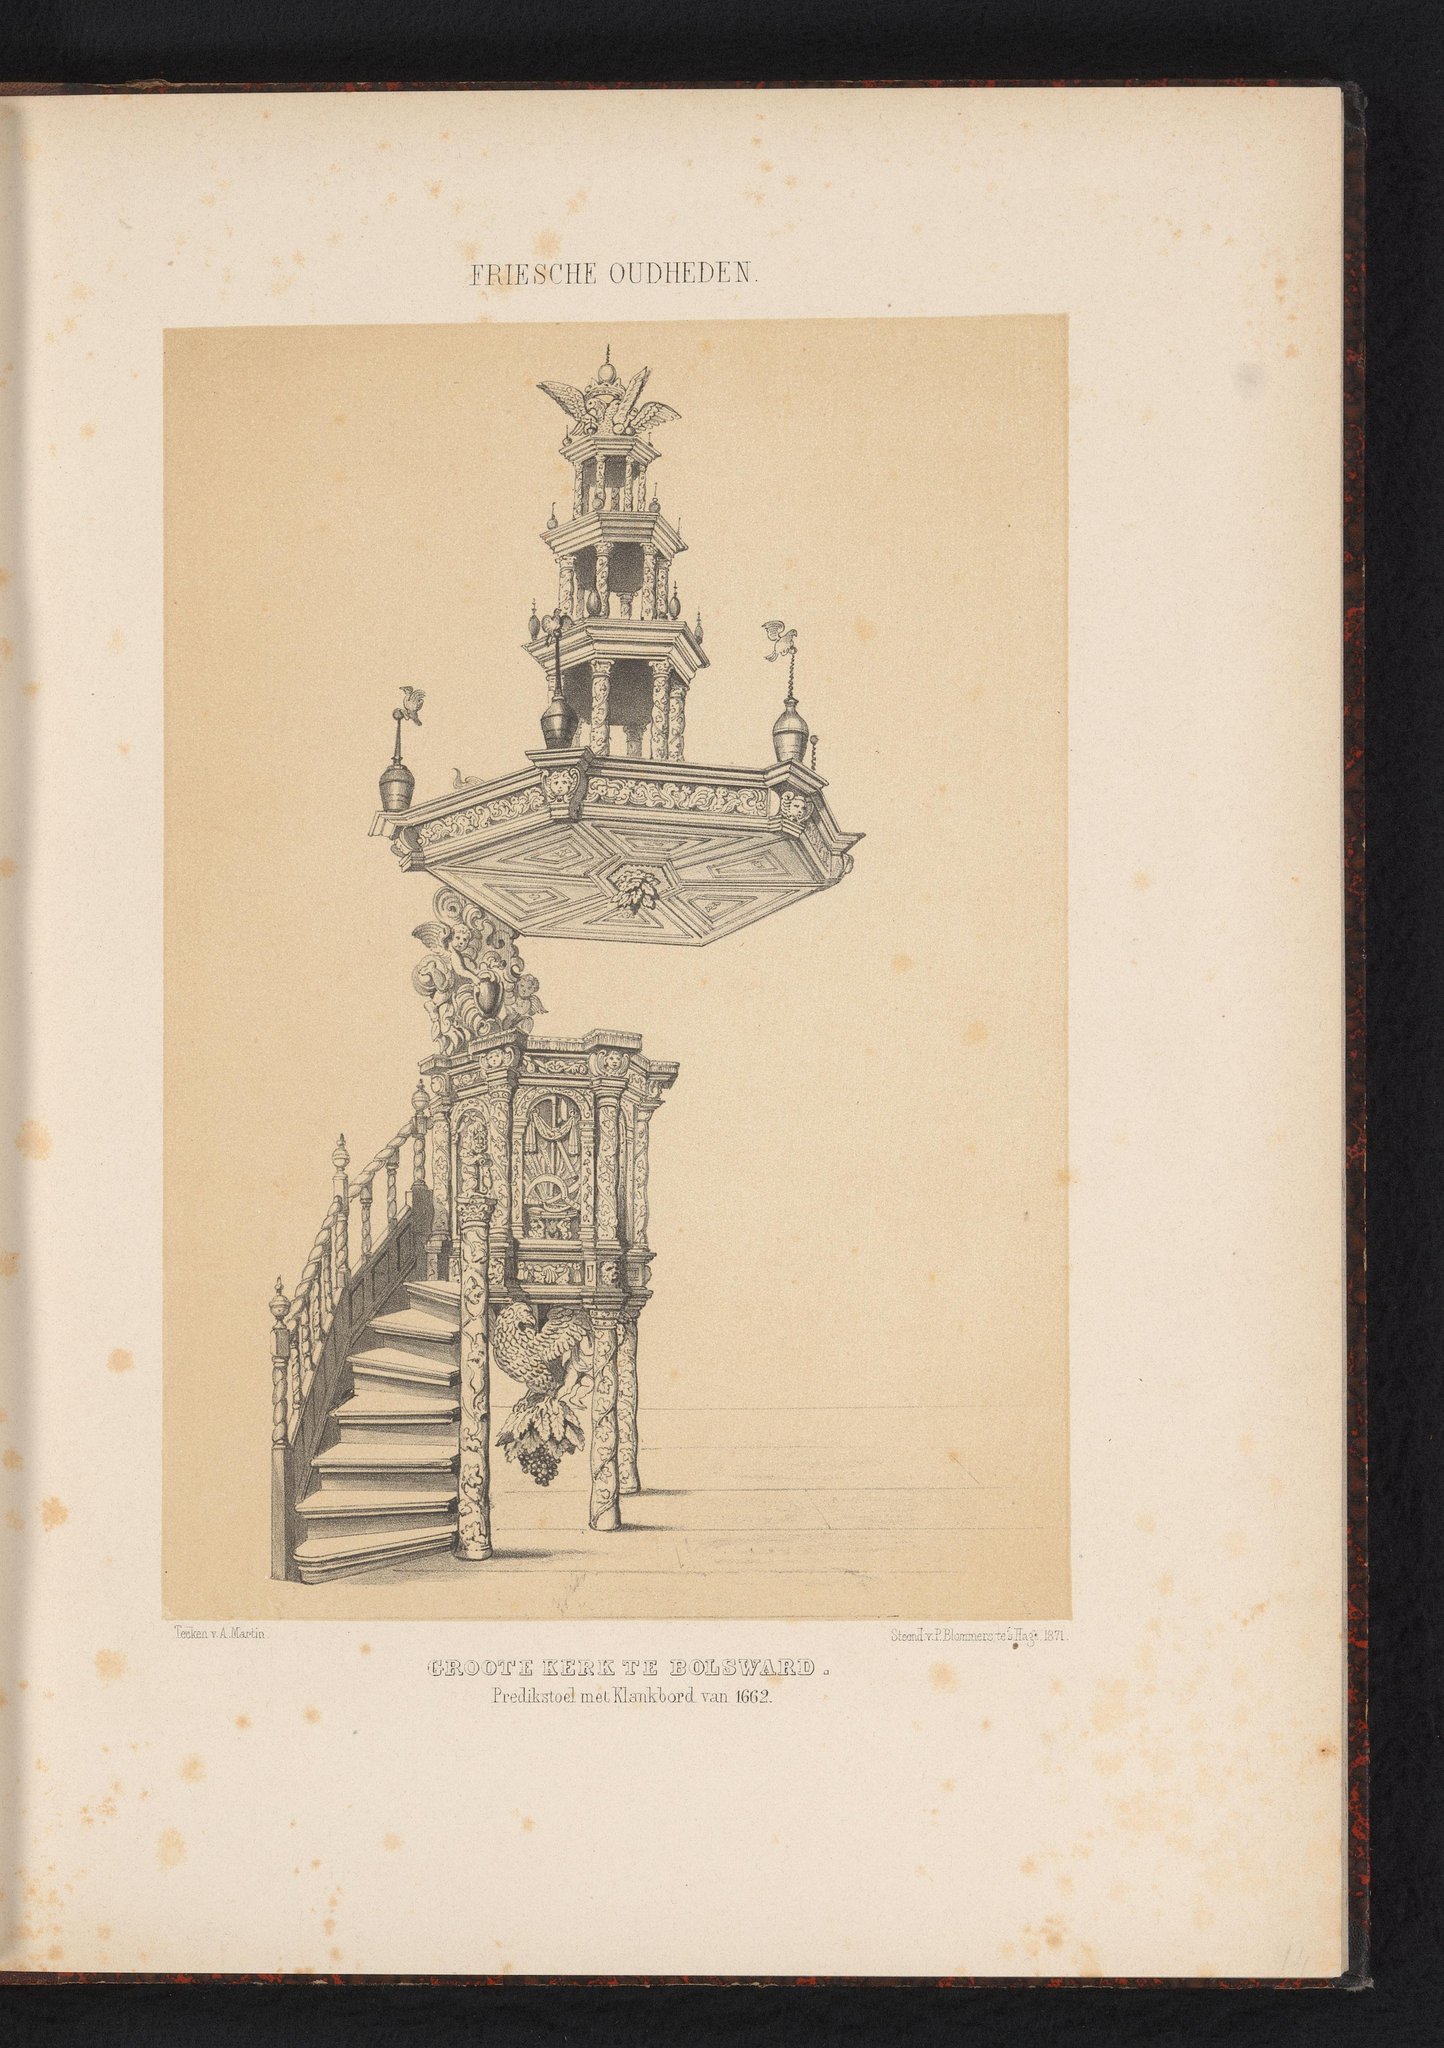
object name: historical object representation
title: Preekstoel in de Grote Kerk te Bolsward, uit 1662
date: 1871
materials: paper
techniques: lithograph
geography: the hague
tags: pulpit, ambo, chancel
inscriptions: date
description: Illustratie in: Friesche Oudheden. Afbeeldingen van merkwaardige voorwerpen van Wetenschap en Kunst, gevonden in de archieven, kerken, kasteelen, terpen enz. van Friesland, Leeuwarden 1875. Niet in Frederik Muller; door het RPK toegevoegd nummer.